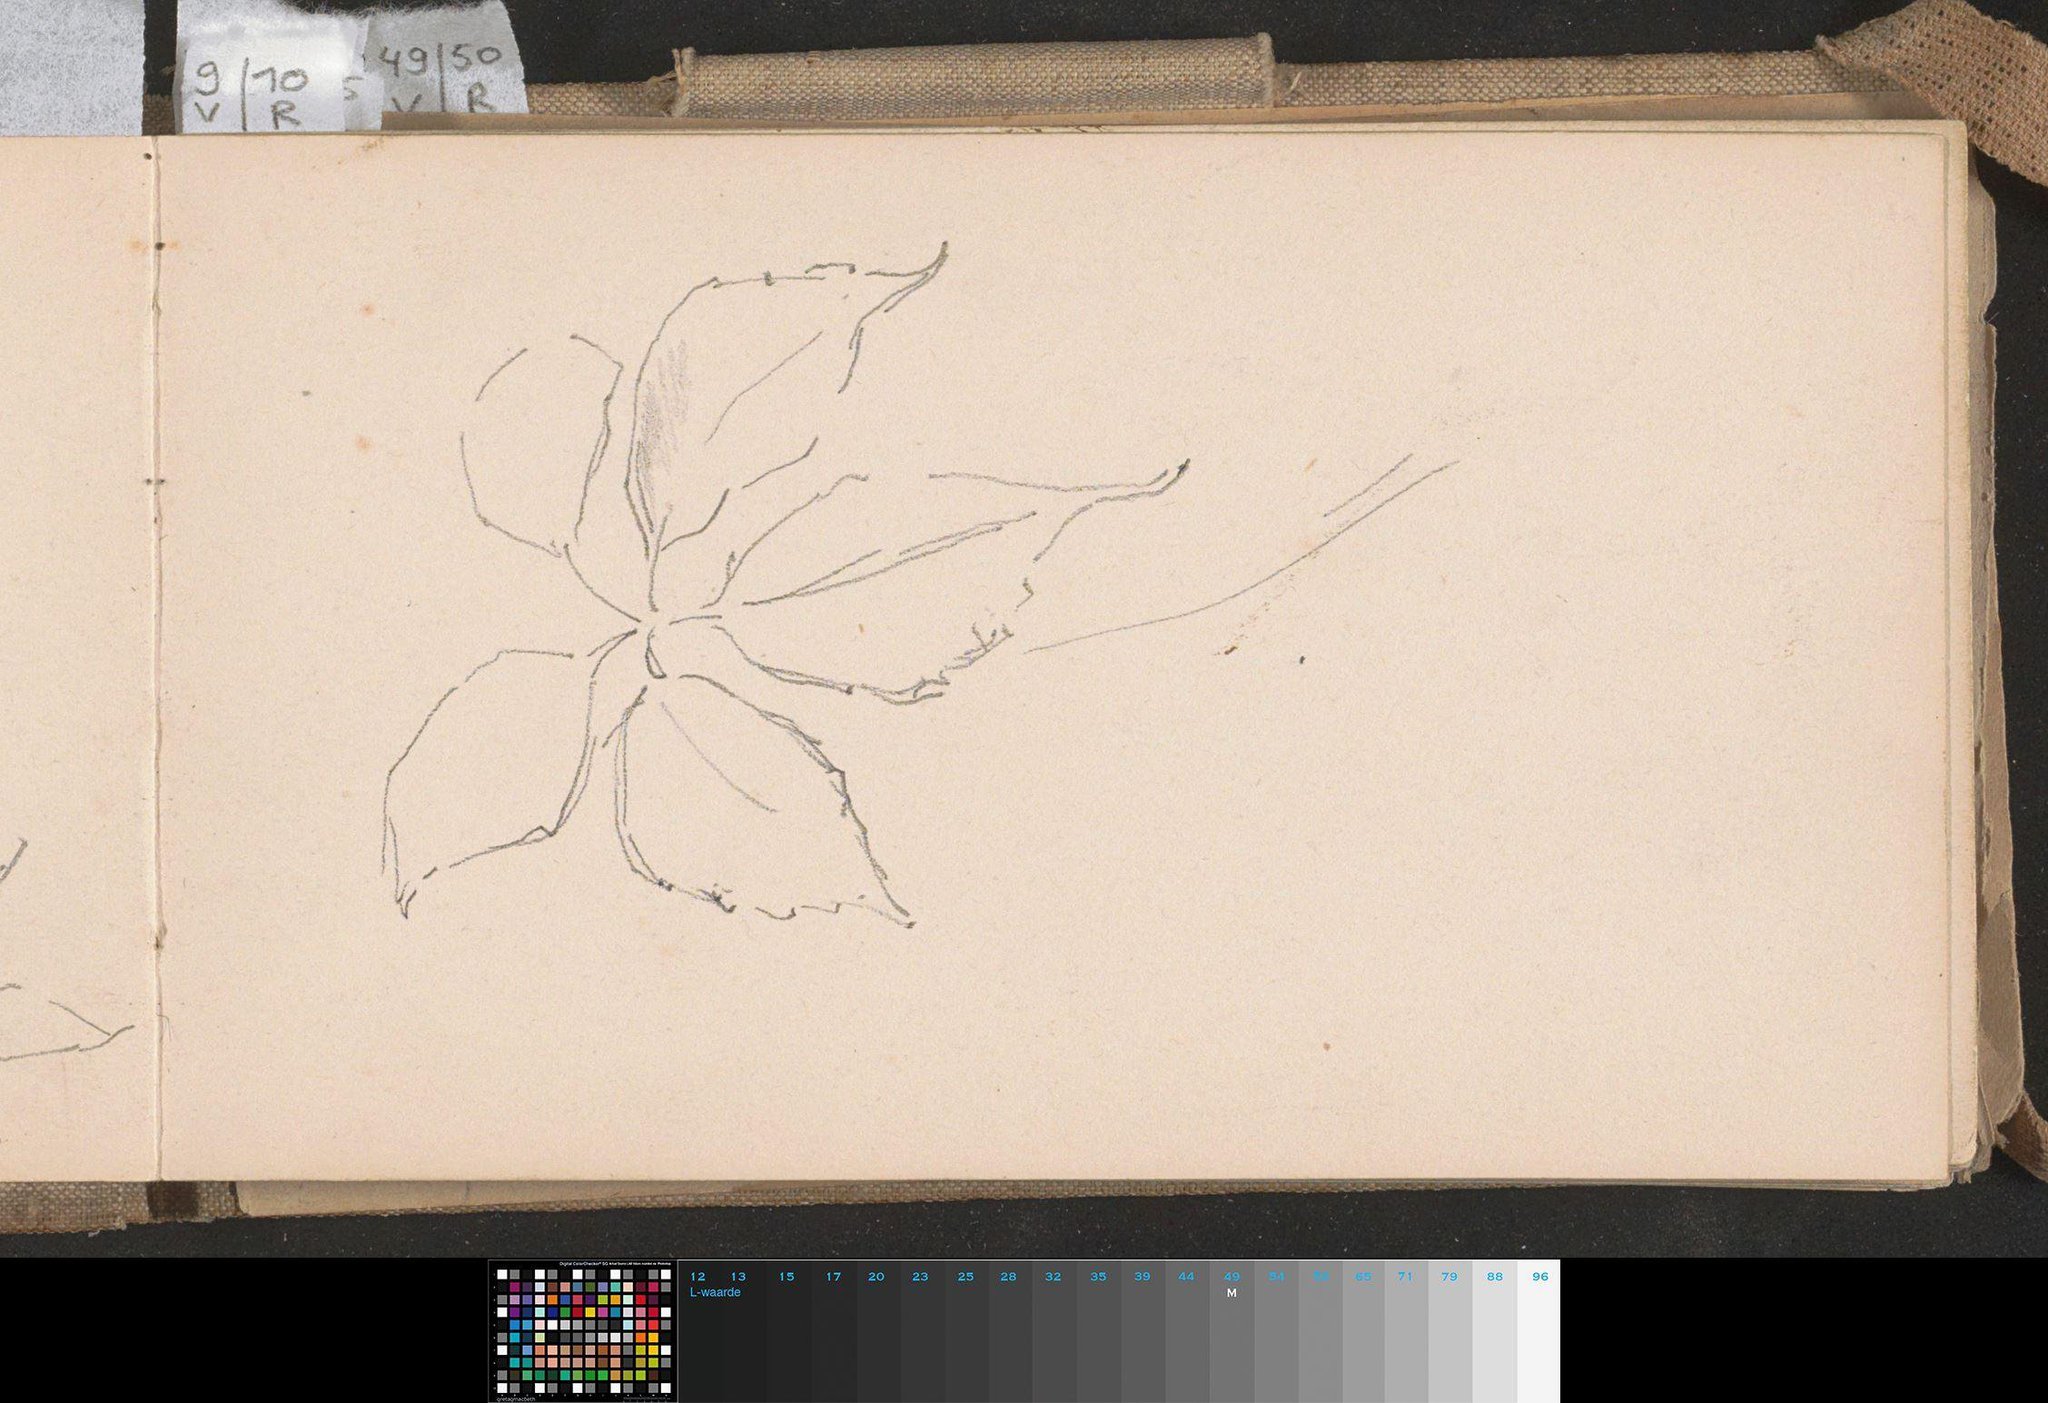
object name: sketchbook leaf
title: Tak met gedeeld blad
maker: antoon derkinderen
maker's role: draughtsman, painter, print maker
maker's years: 1859-1925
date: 1892-1901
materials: paper, pencil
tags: plants (in general) (+ leaf)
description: Blad 6 recto uit een schetsboek met 51 bladen.